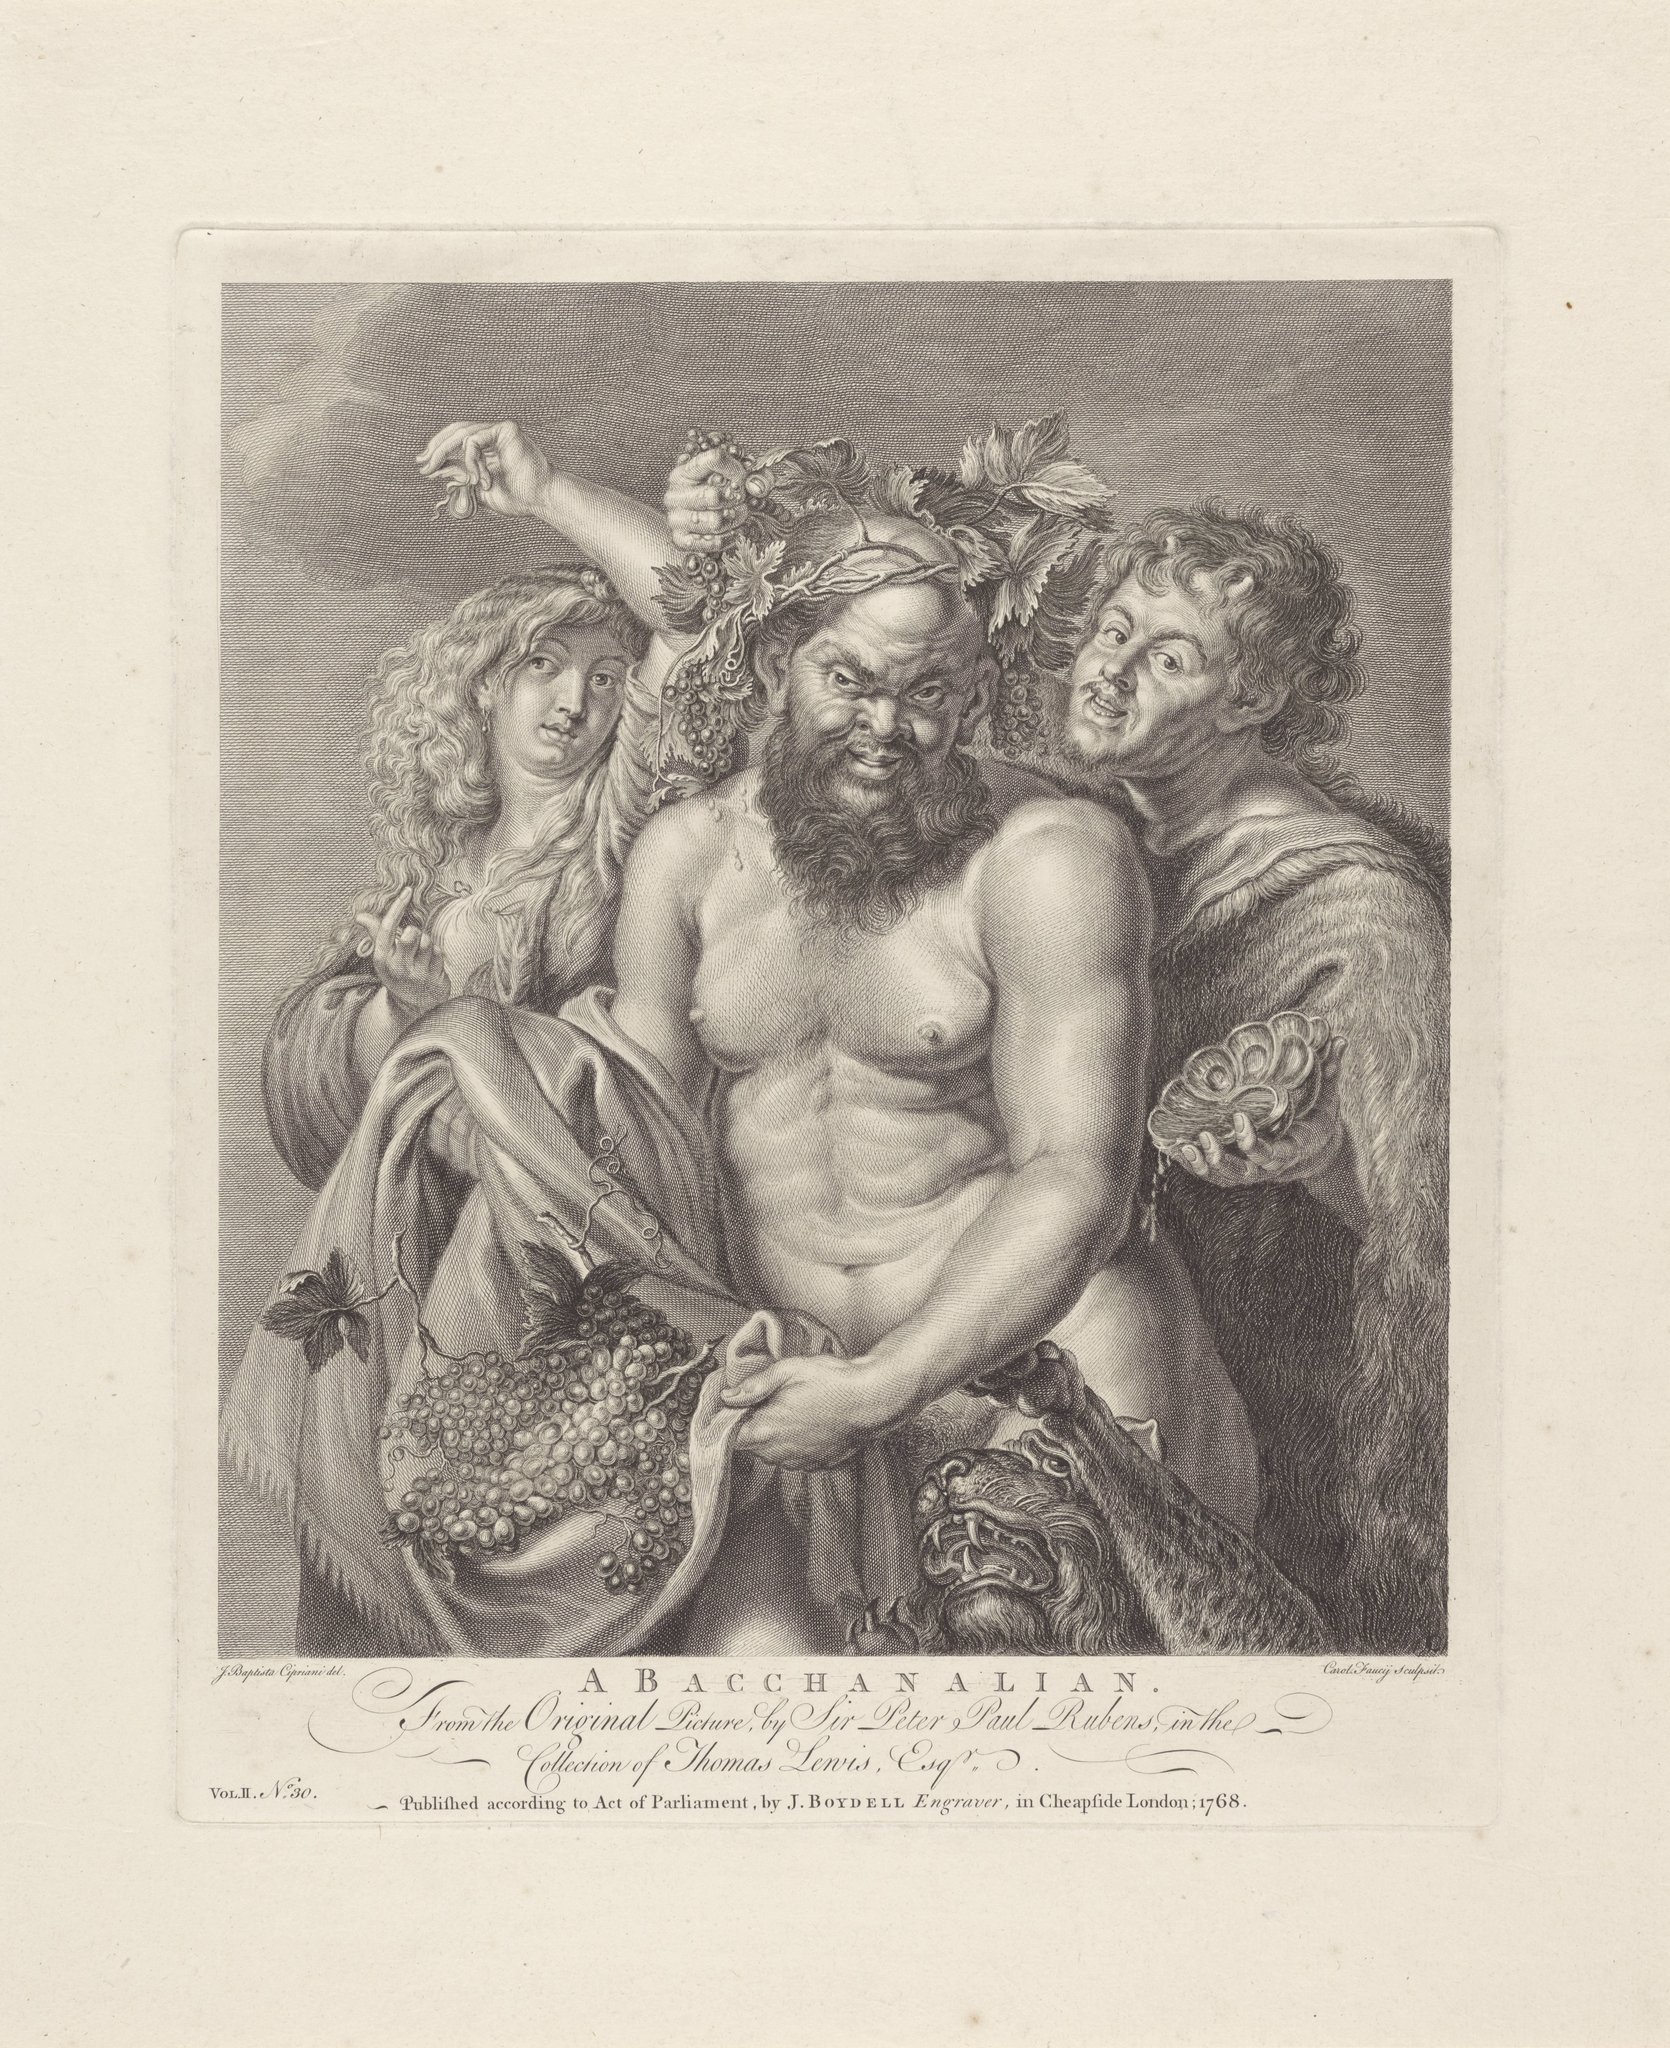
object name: print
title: A Bacchanalian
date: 1768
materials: paper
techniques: engraving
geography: london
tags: (story of) bacchus (dionysus), liber, maenad(s), female bacchant(es), nymphs (in general); 'ninfe in commune' (ripa)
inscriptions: collector's mark: Lugt 2228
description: De wijngod Bacchus, een Bacchante, een sater en een panter. Genummerd linksonder: Vo. II. No. 30.